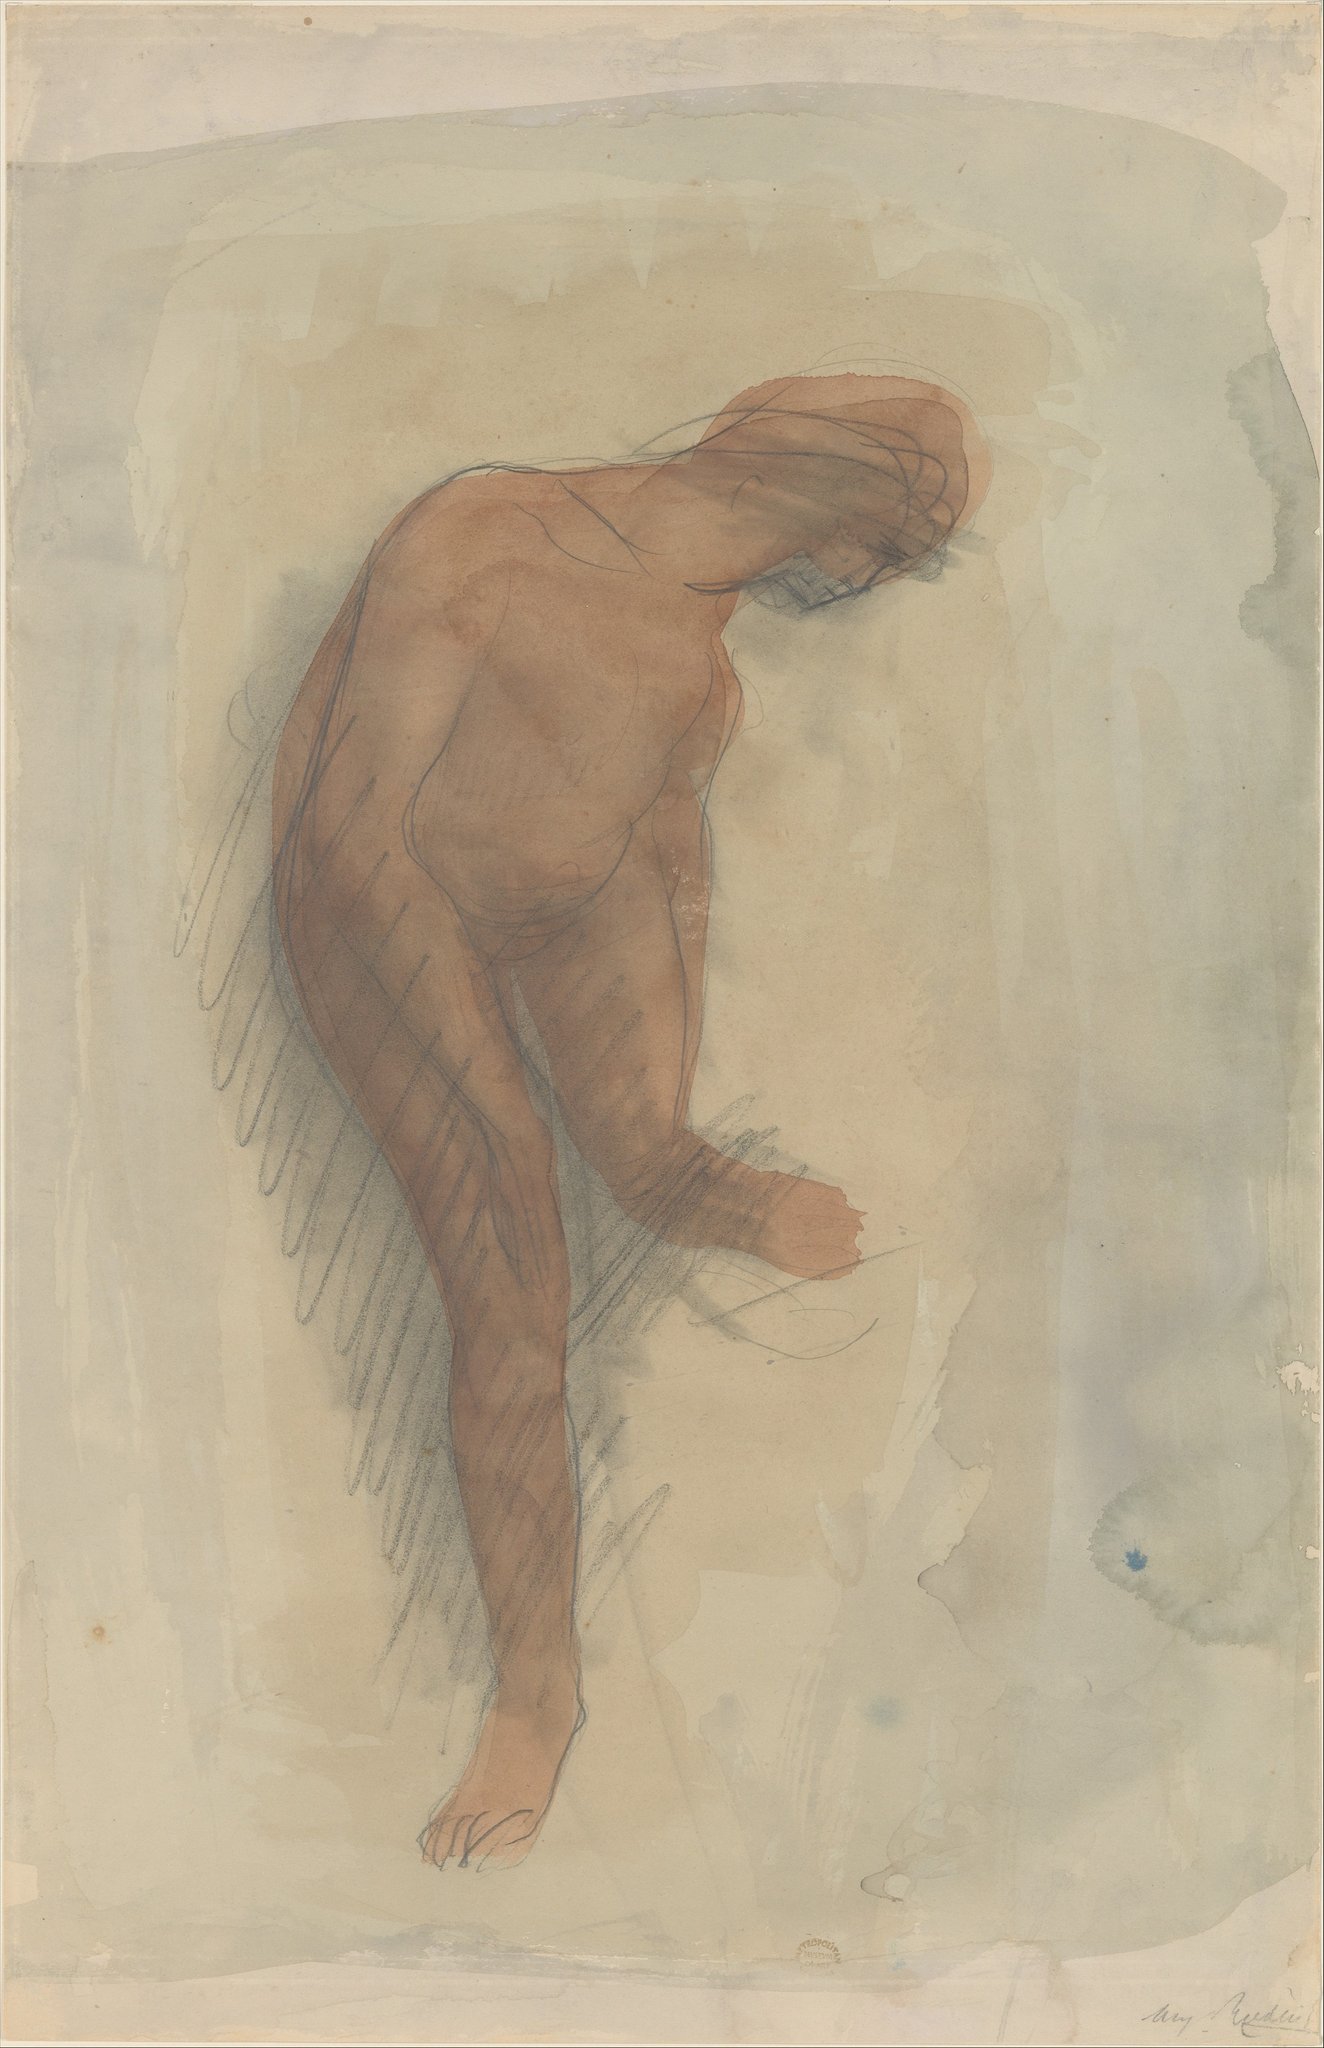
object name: drawing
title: Nude female figure holding left foot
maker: auguste rodin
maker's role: artist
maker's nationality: french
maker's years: 1840-1917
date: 1900-1912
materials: graphite, watercolor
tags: female nudes